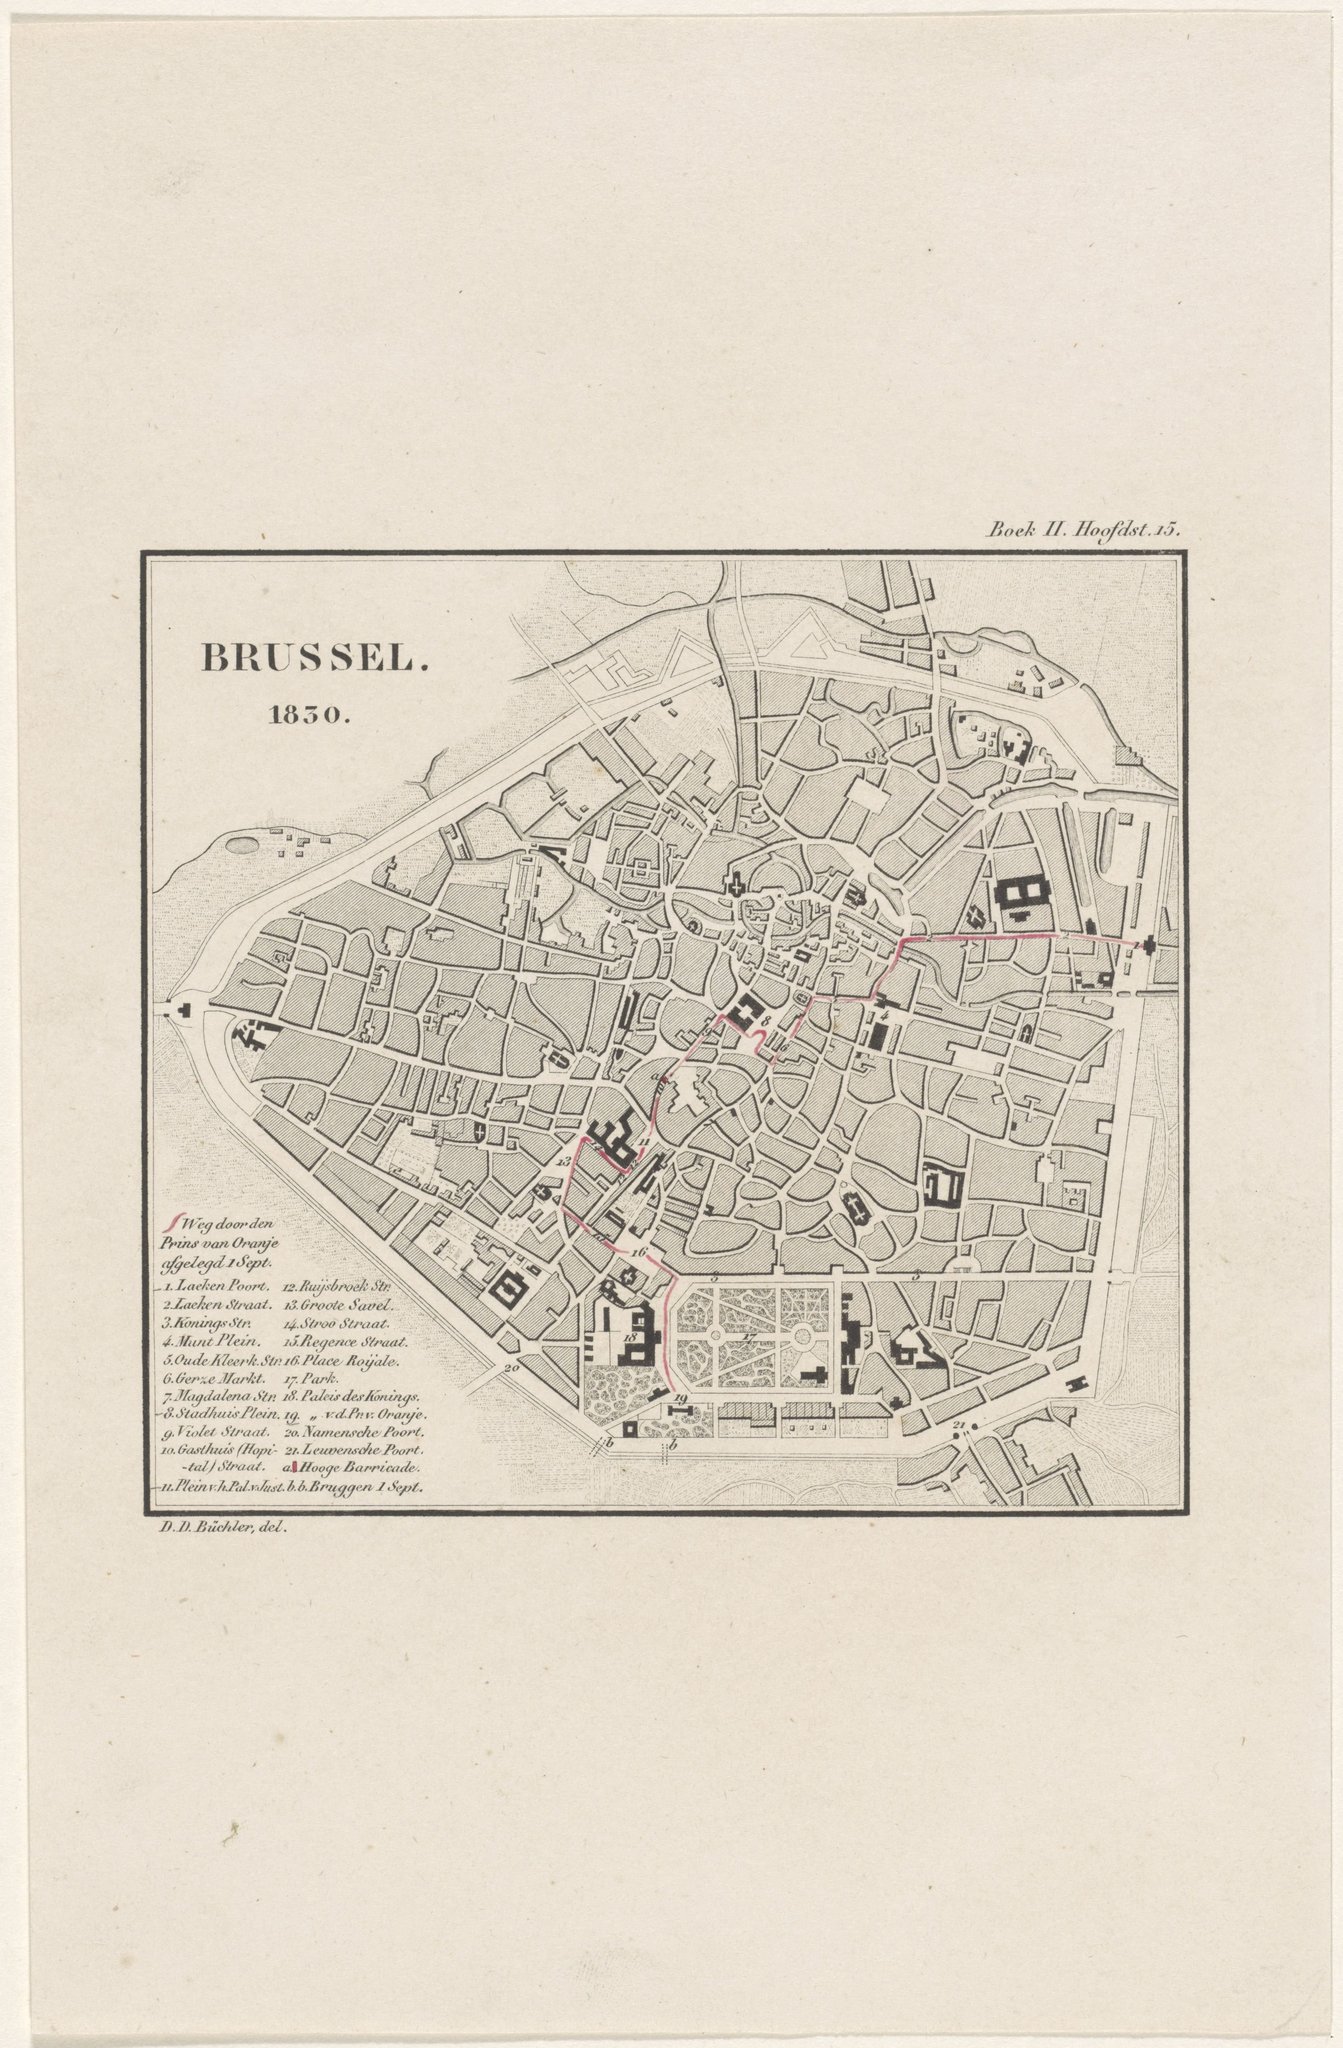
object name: history print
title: Plattegrond van Brussel met de route van de prins van Oranje, 1830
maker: daniël david büchler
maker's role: architect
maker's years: 1787-1881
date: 1850-1852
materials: paper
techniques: lithograph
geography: netherlands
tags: the hague, william ii of the netherlands, maps of cities, brussels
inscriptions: collector's mark: Lugt 2228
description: Gebruikt als illustratie in: Johannes Bosscha, Het leven van Willem den Tweede : koning der Nederlanden en groot-hertog van Luxemburg, Amsterdam: Van Gogh, 1852.